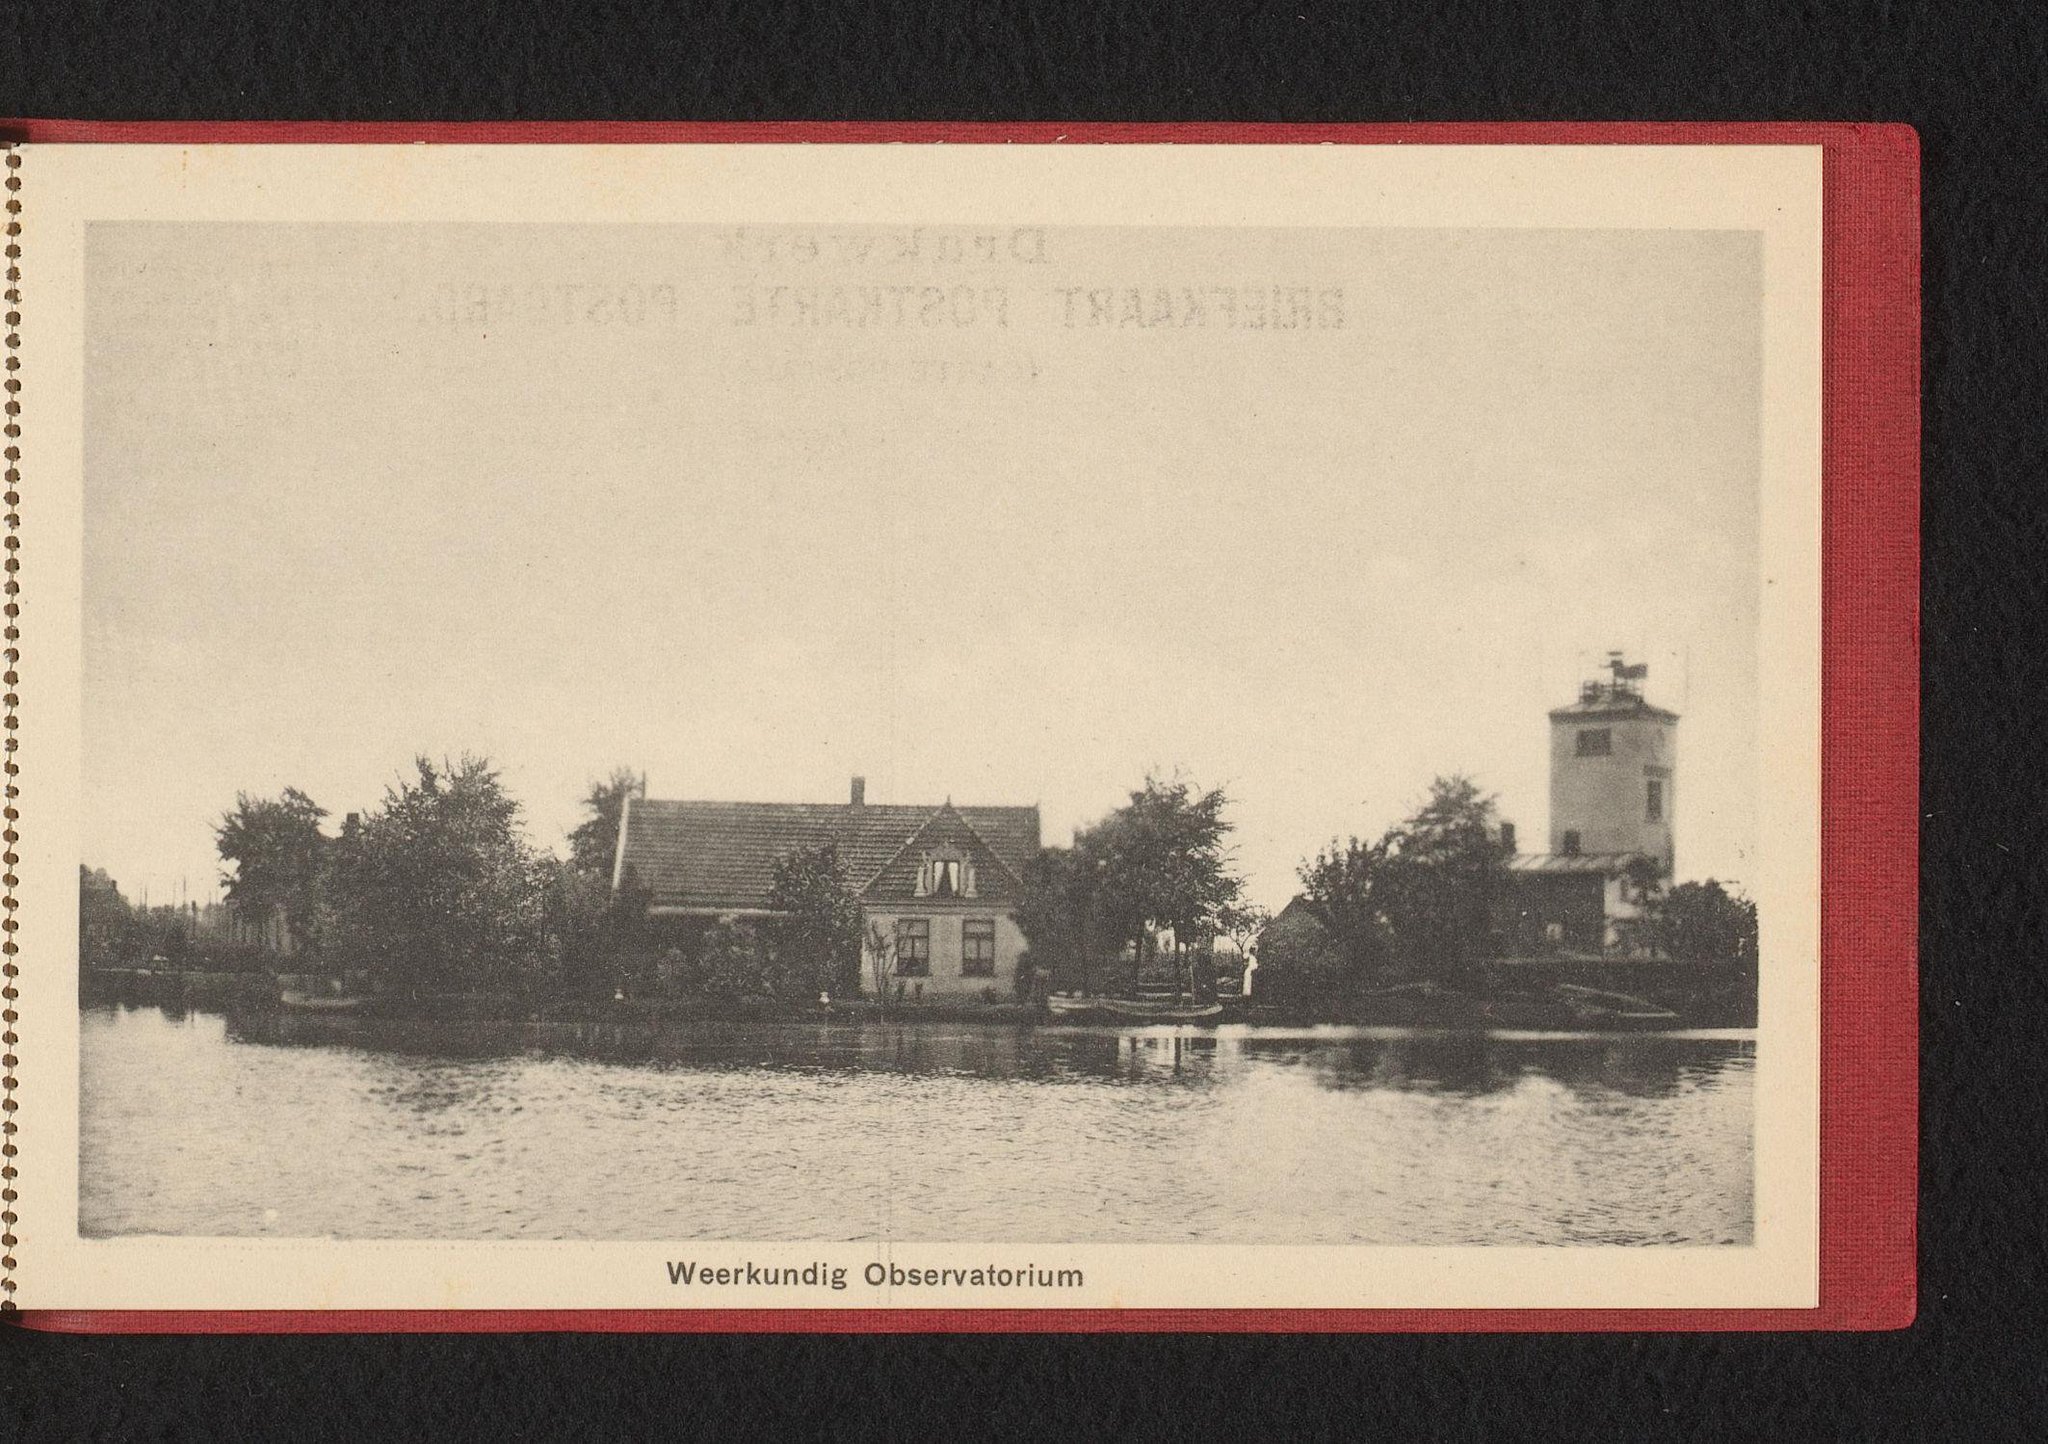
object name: photomechanical print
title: Weerkundig Observatorium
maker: Anonymous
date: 1906-1915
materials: cardboard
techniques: photograph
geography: amsterdam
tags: river, meteorological observatory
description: Prentbriefkaart maakt deel uit van een album.